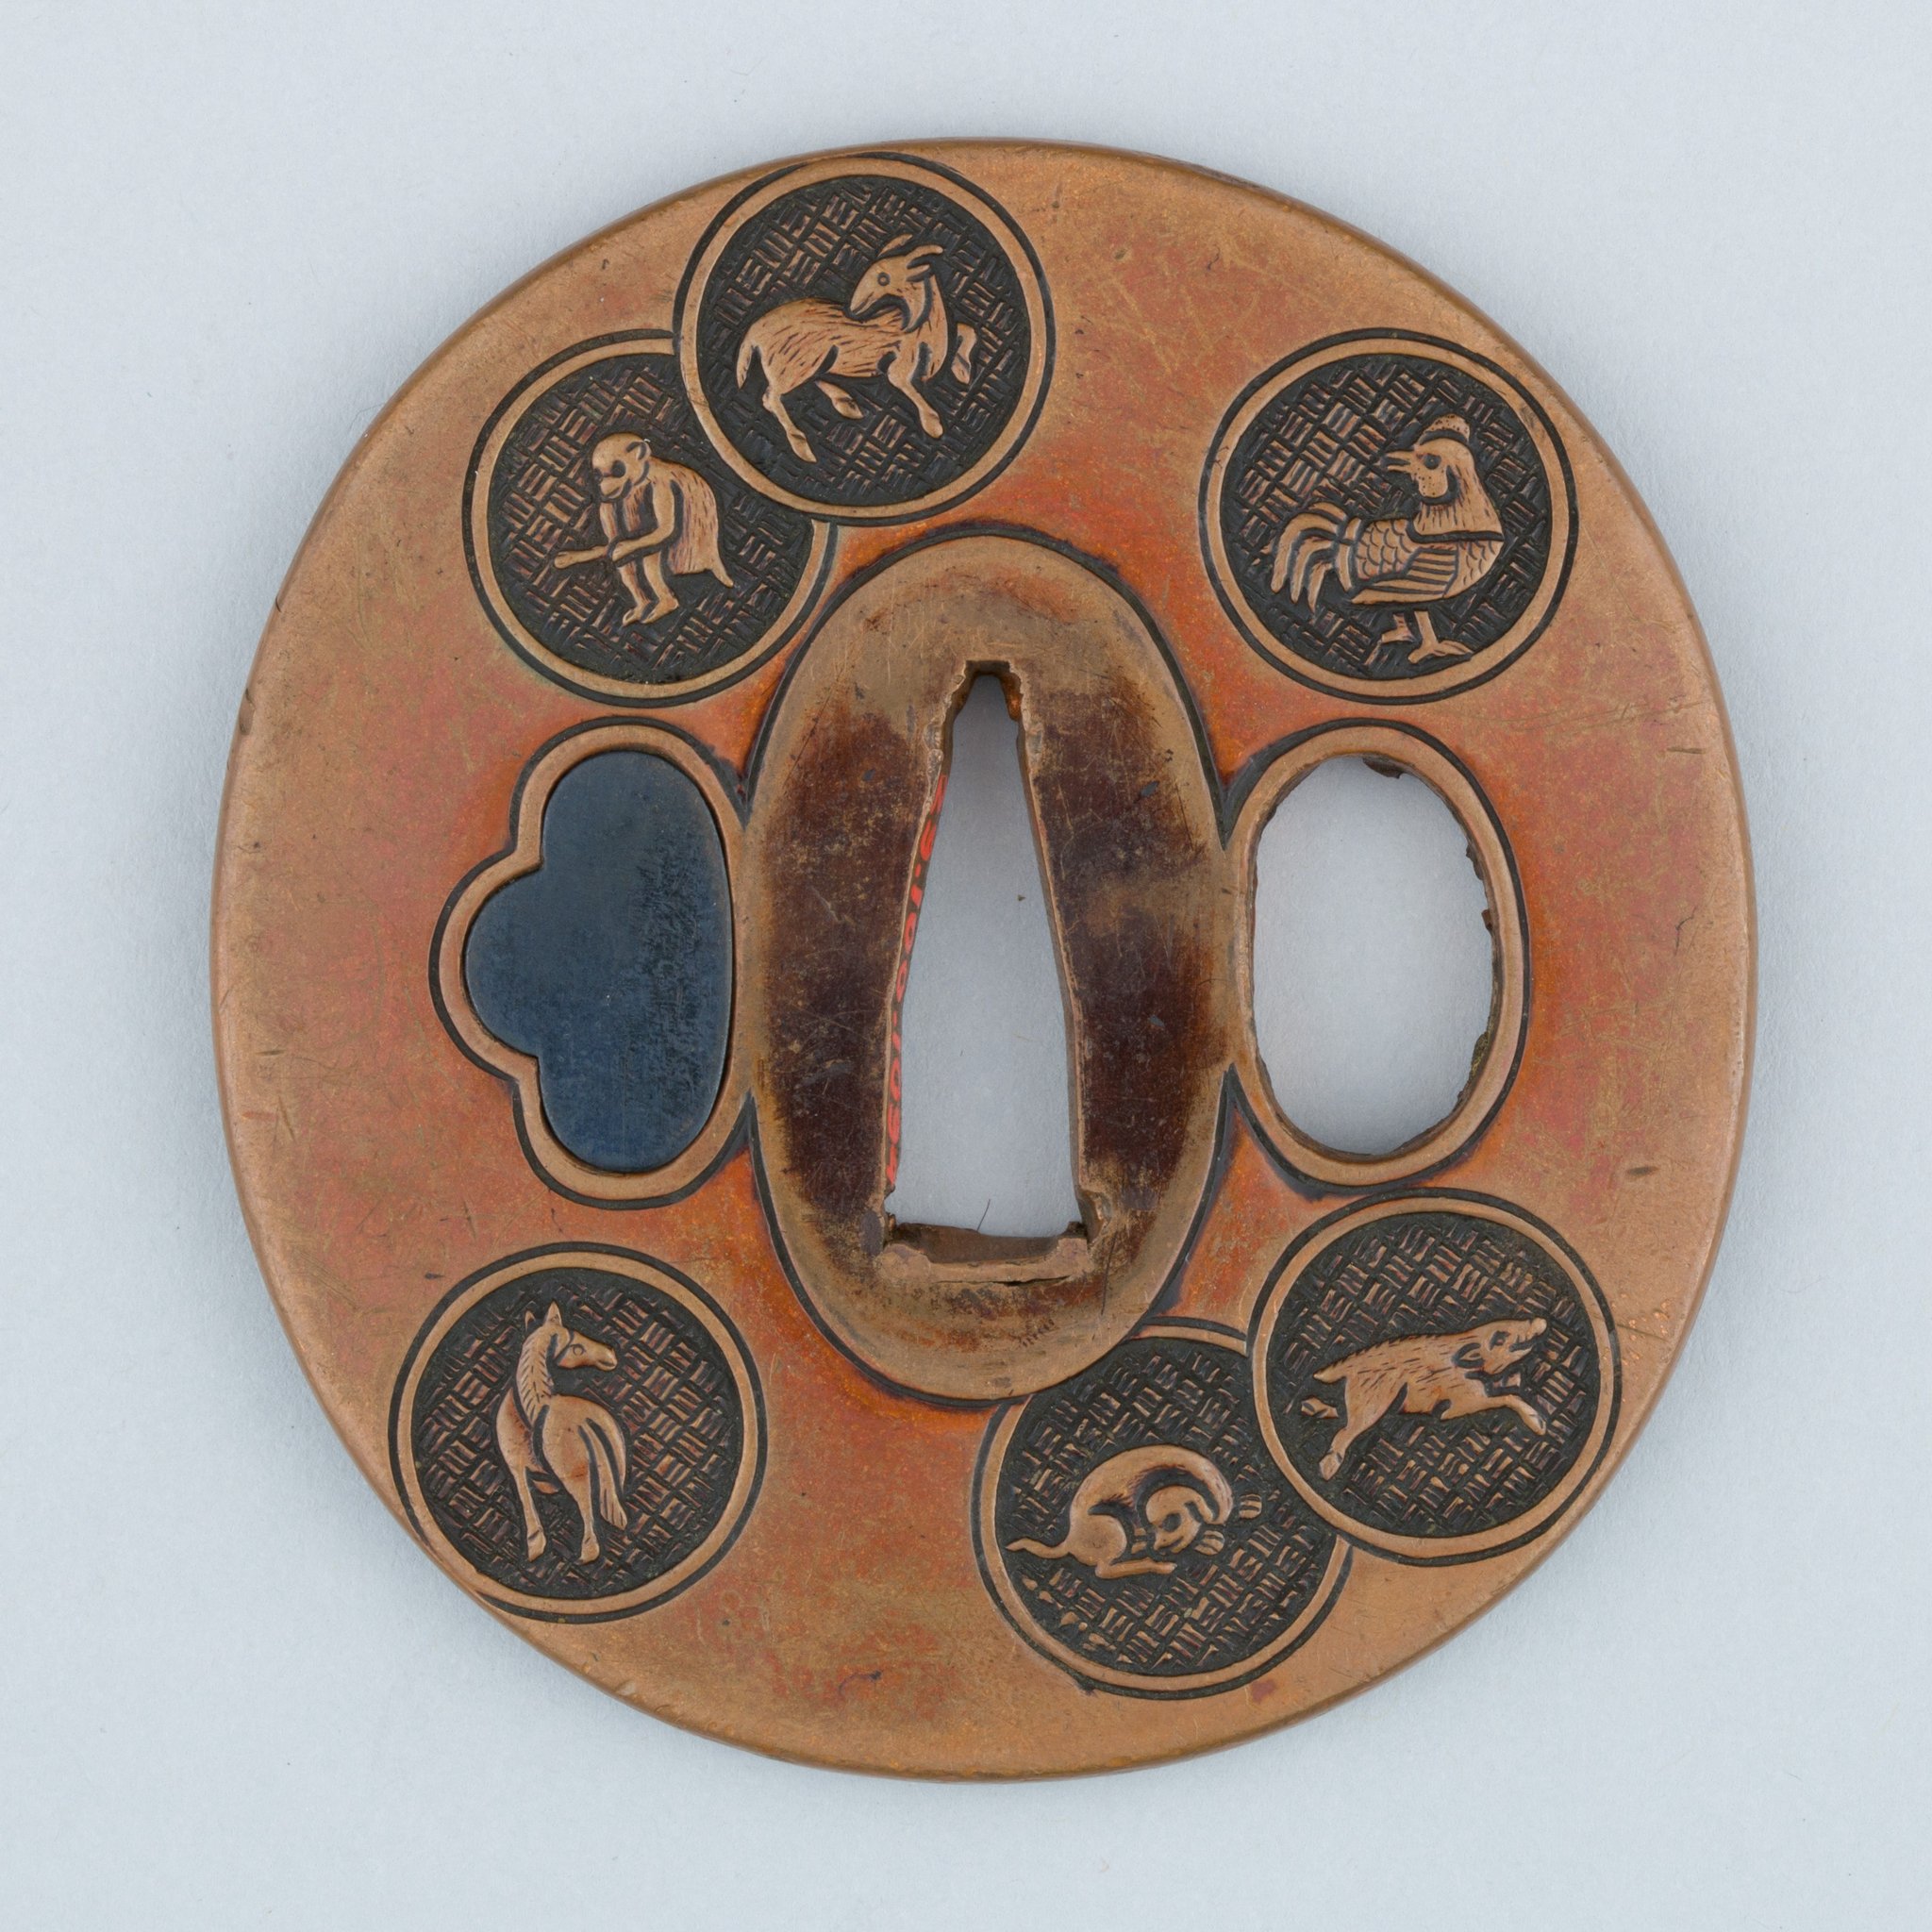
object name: sword guard tsuba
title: Sword Guard (Tsuba)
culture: japanese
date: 1615-1868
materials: copper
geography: japan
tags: roosters,dogs,horses,monkeys,pigs